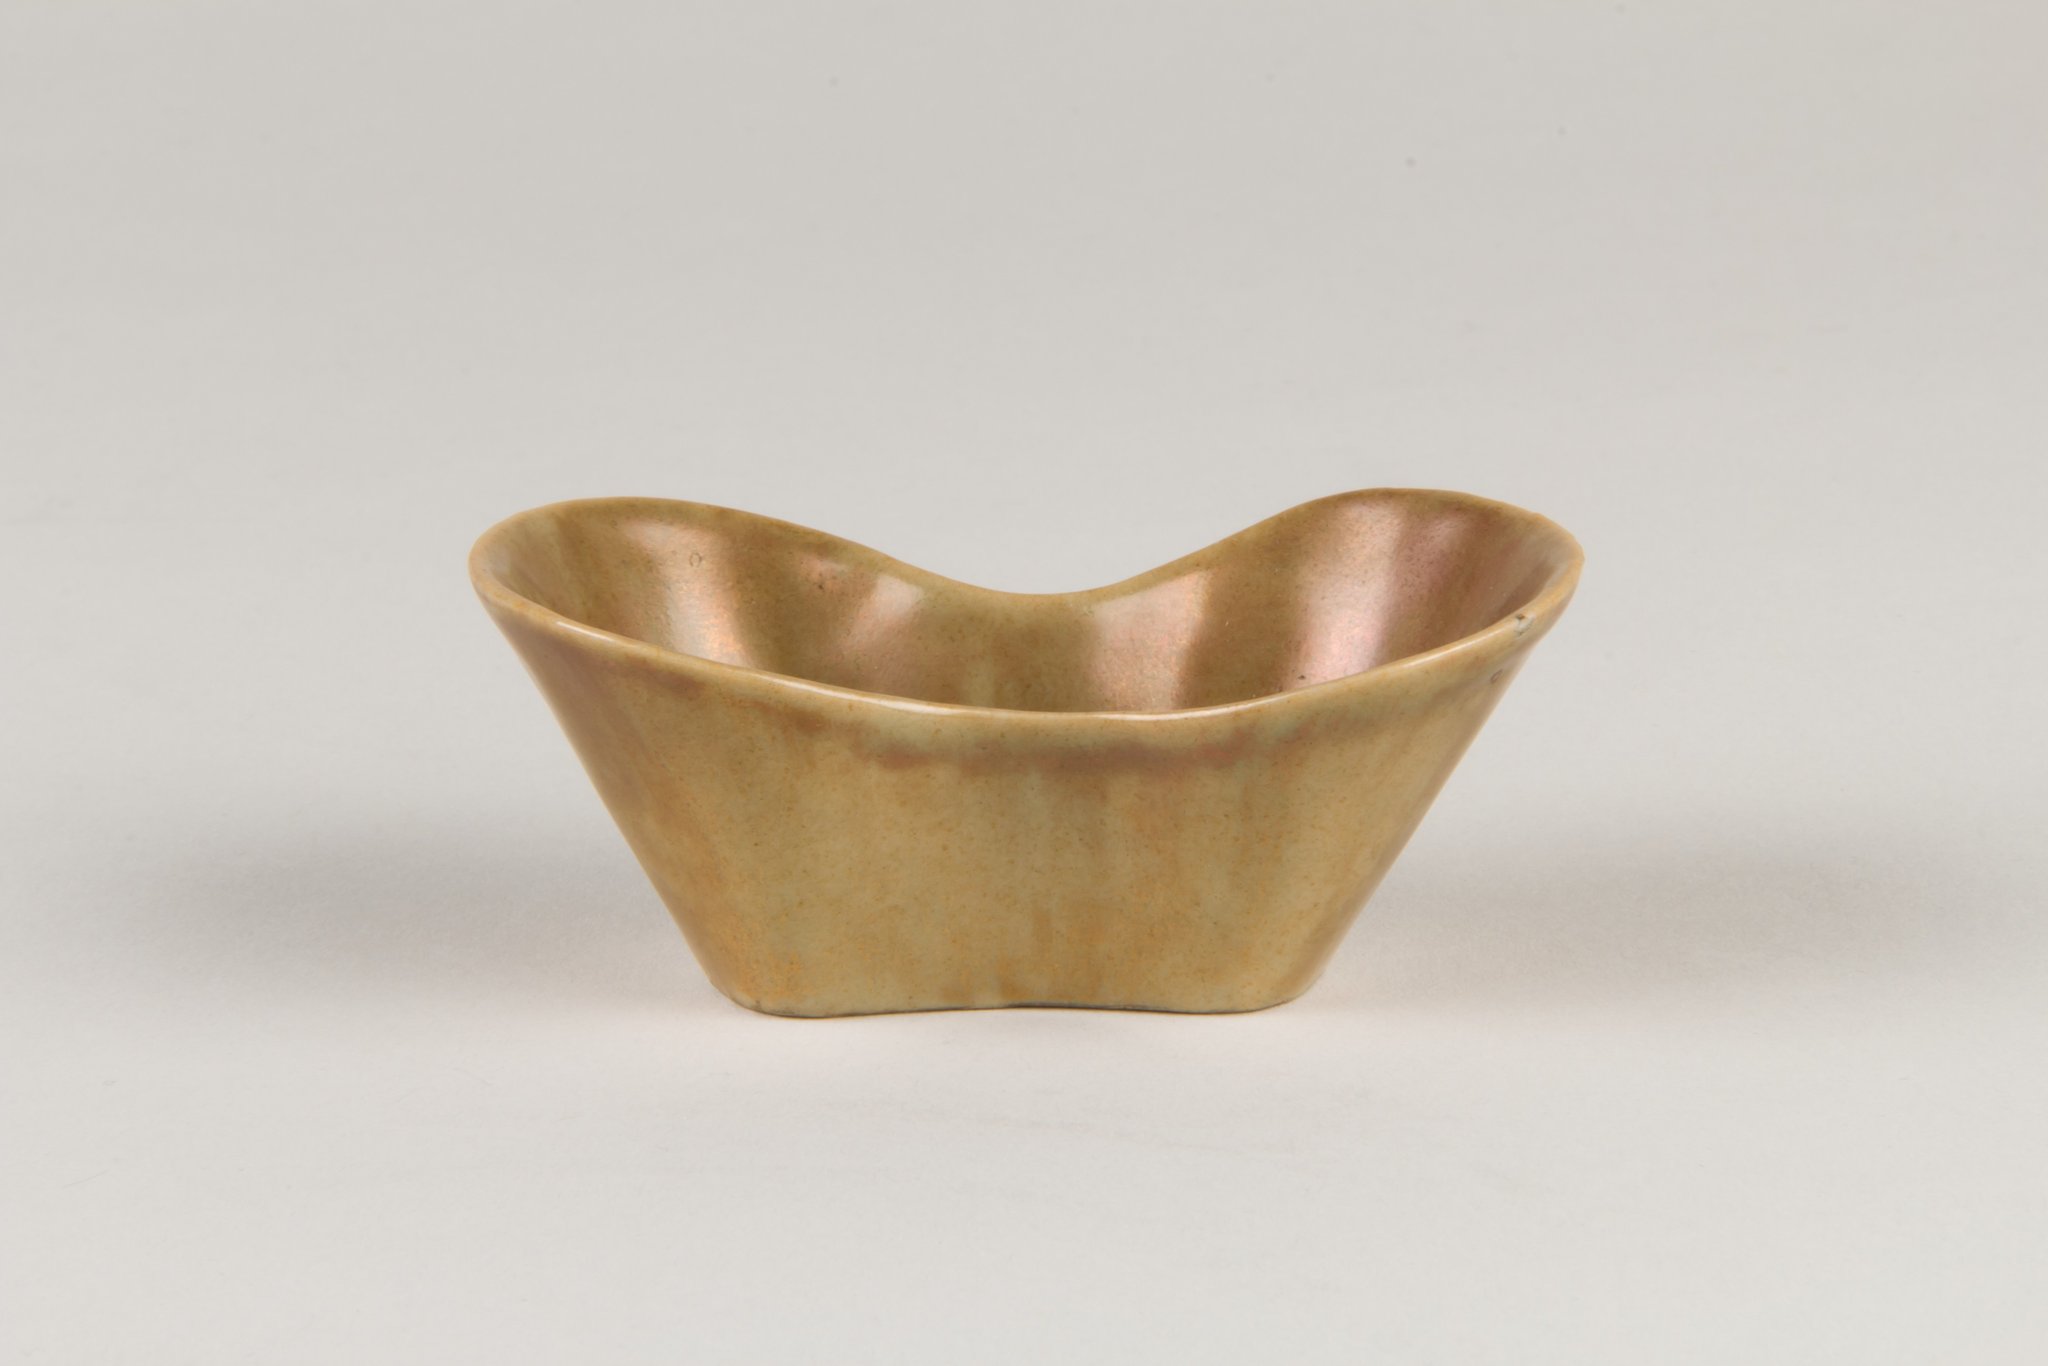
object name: cup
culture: chinese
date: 1801-1850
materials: gilt, porcelain